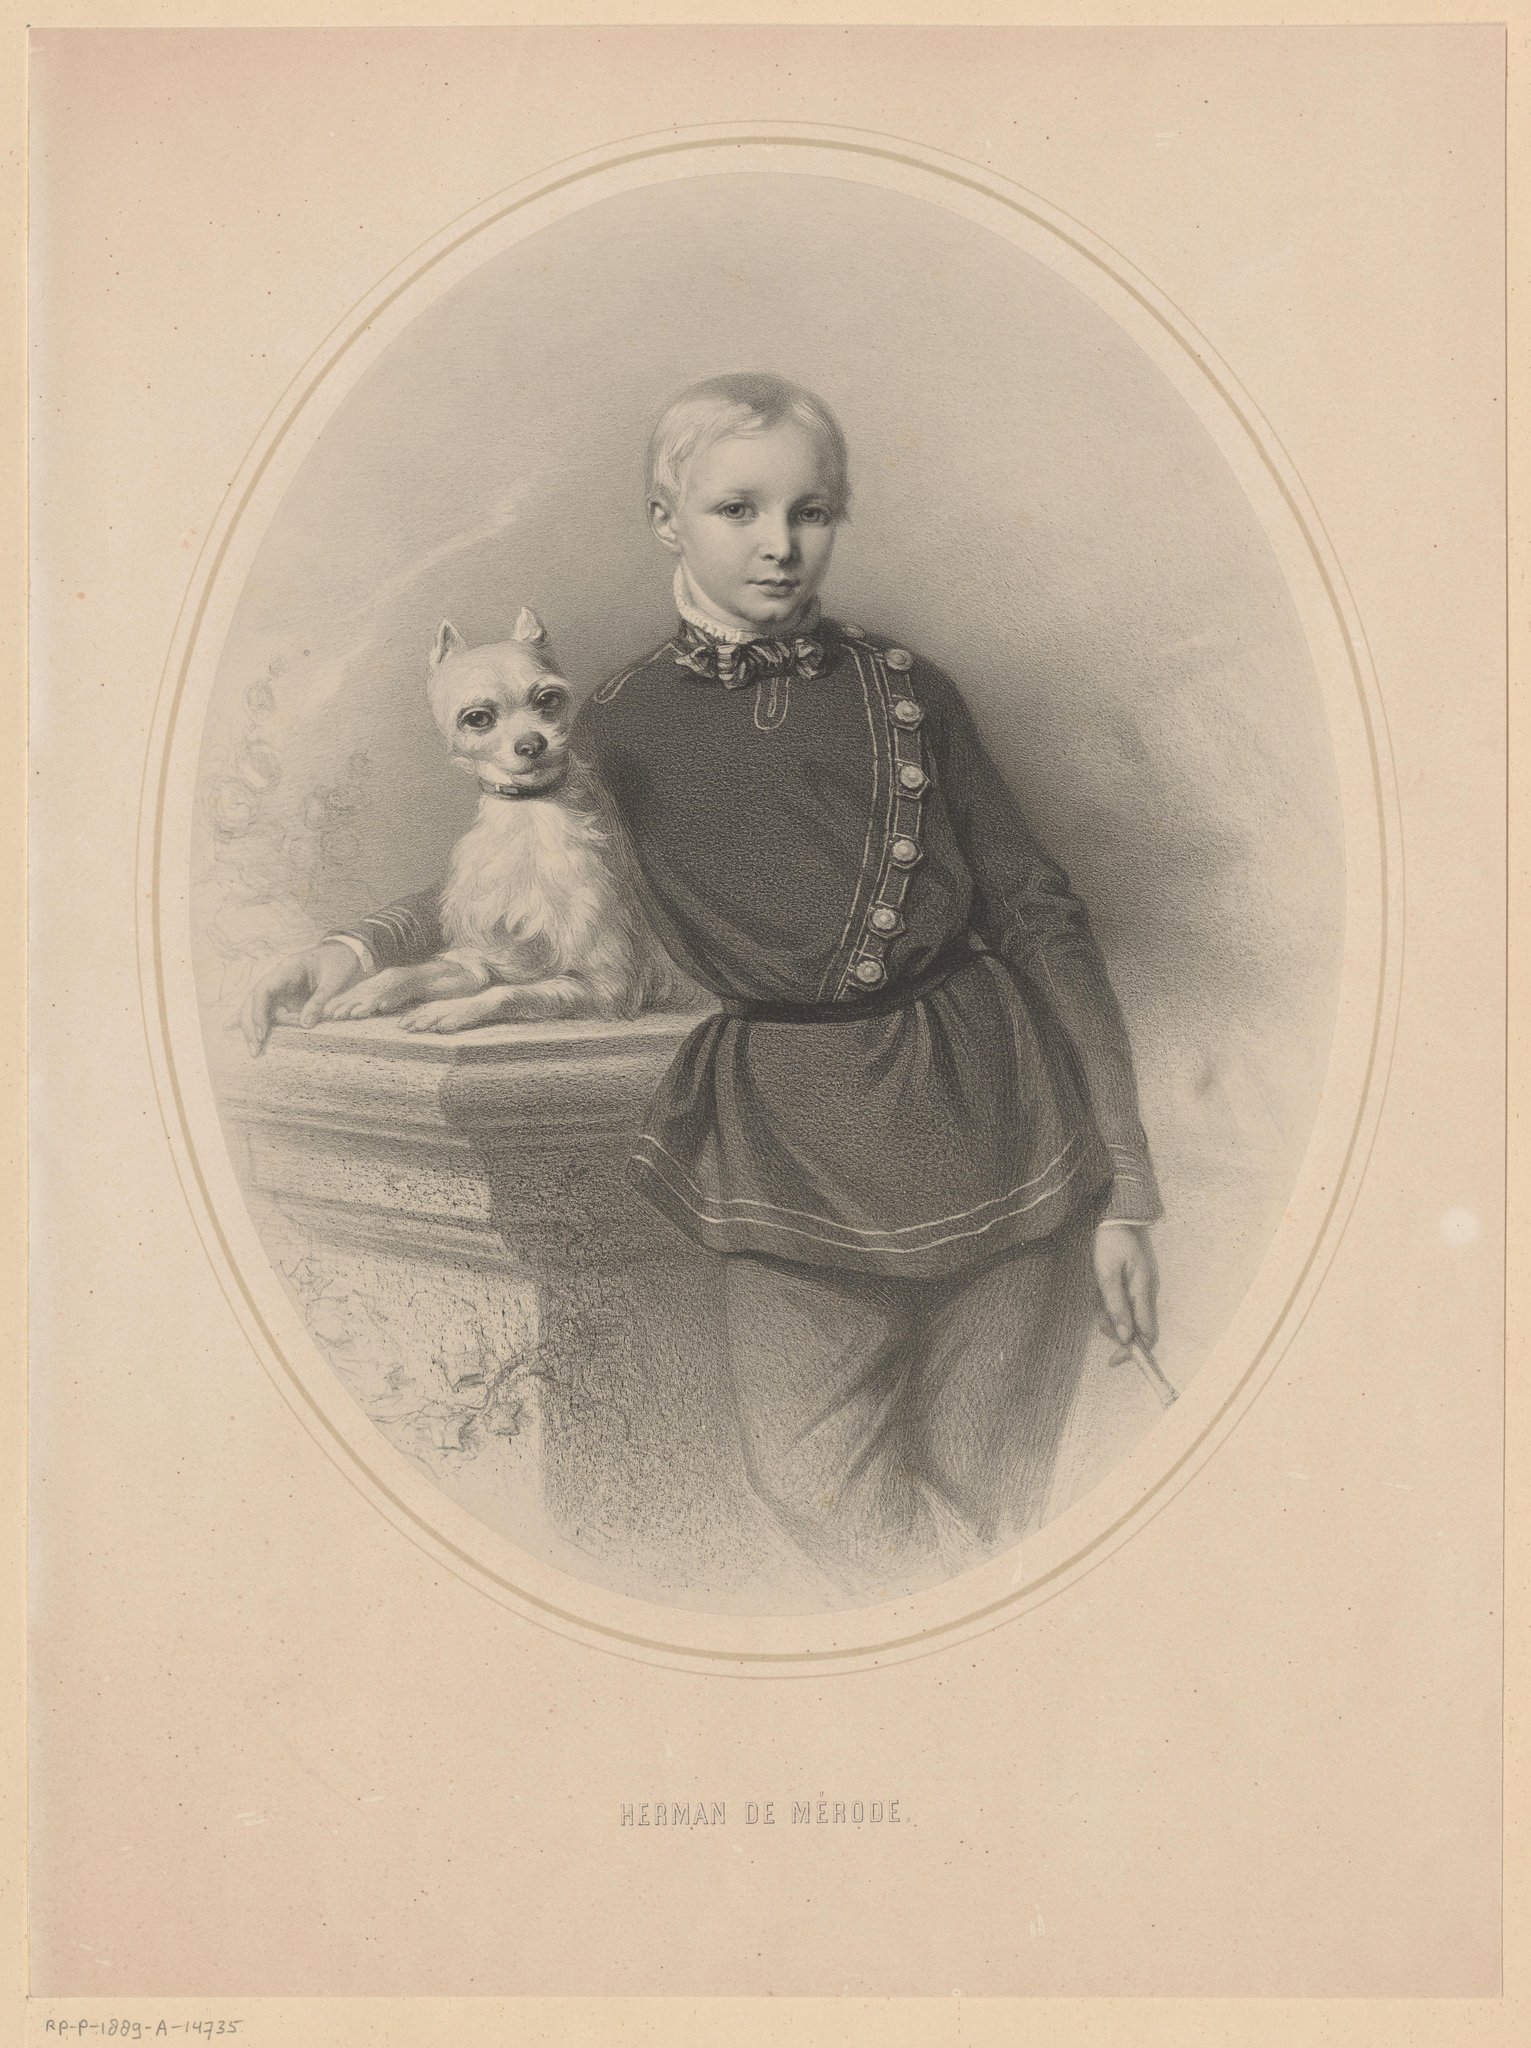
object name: print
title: Portret van Herman de Mérode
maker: joseph schubert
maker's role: print maker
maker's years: 1816-1885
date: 1850-1885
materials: paper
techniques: lithograph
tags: anonymous historical person portrayed alone, dog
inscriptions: collector's mark: Lugt 2228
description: Niet bekend welke Herman de Mérode, mogelijk Richard Hermann de Mérode (1844-1852) of Hermann de Mérode (1853-1924).